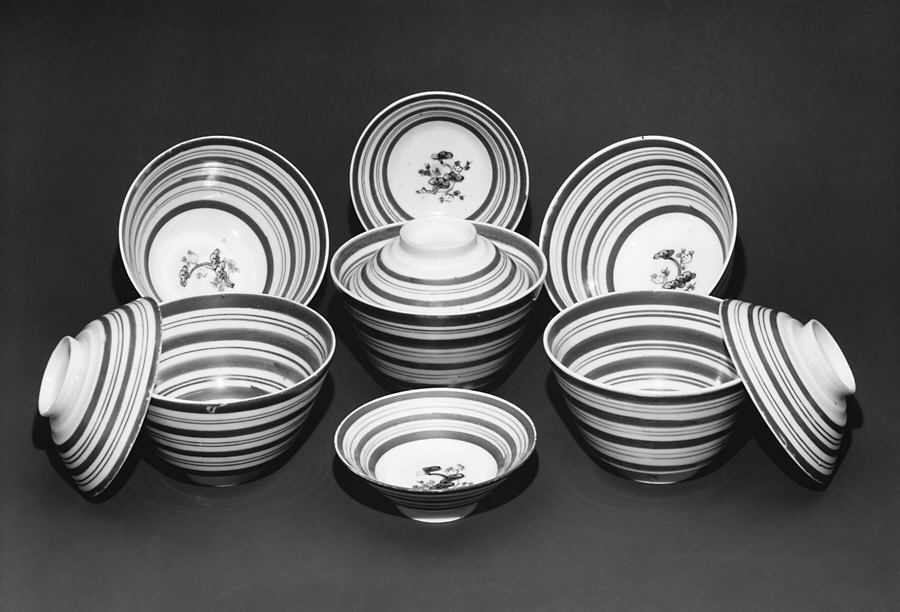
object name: covered bowl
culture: japanese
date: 1701-1800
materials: porcelain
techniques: underglaze